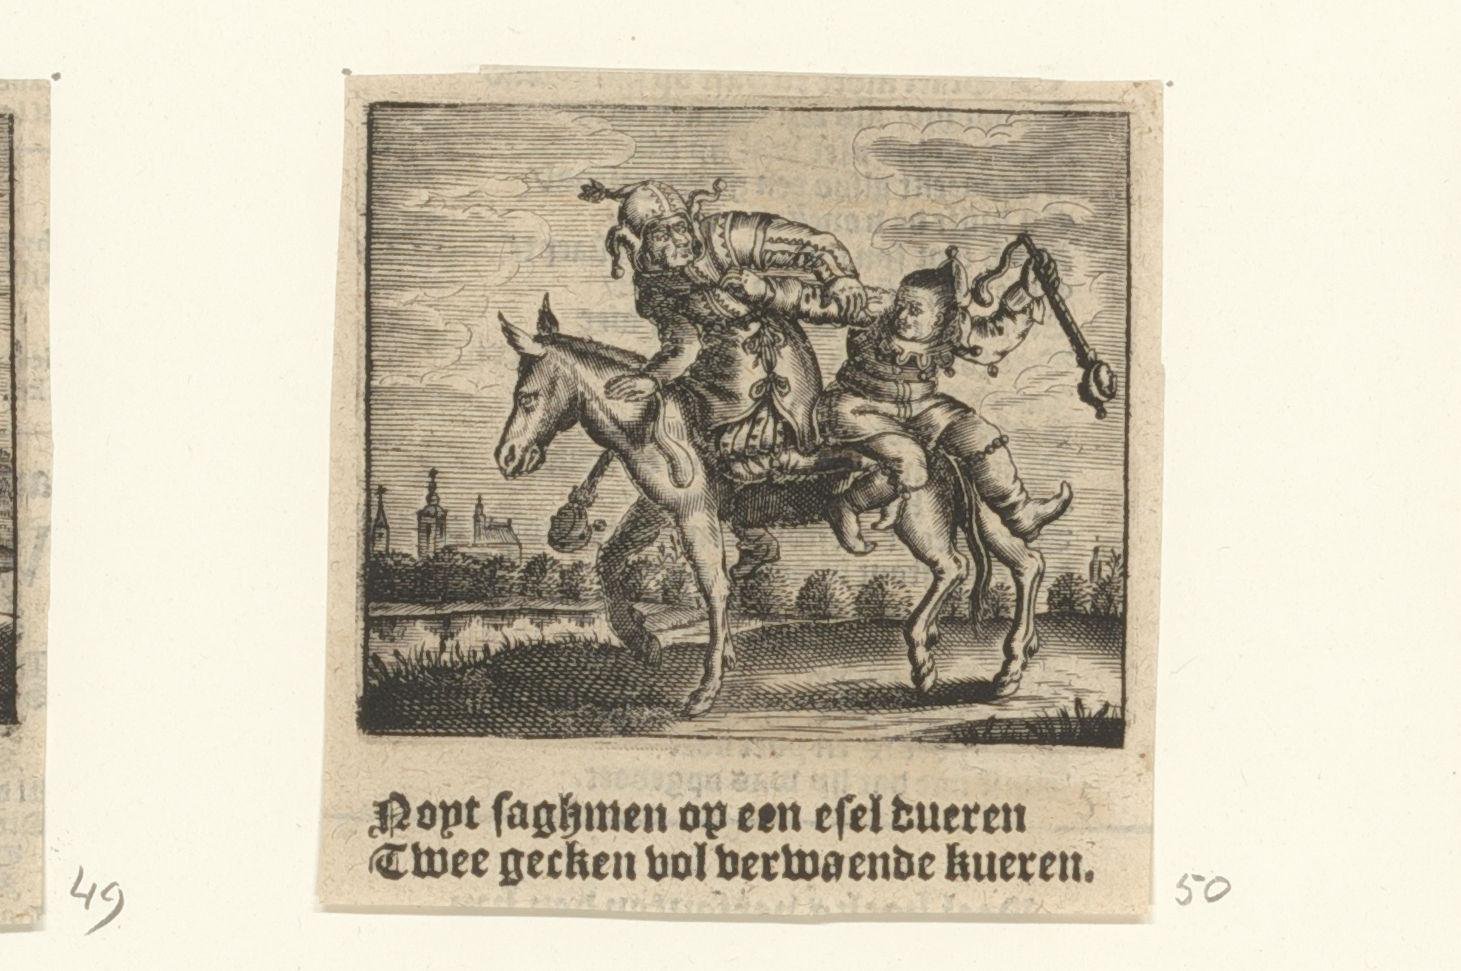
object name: book illustration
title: Noyt saghmen op een esel dueren / Twee gecken vol verwaende kueren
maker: Anonymous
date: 1635-1715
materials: paper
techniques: engraving, letterpress printing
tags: court jester, court fool, proverbs, sayings, etc.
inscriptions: stamp, collector's mark: Lugt 1641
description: Veel versies van dit embleem verschenen in verschillende uitgave van Spiegel van den Ouden ende Nieuwen Tydt. Zoals: Cats, Jacob. Spiegel van den Ouden ende Nieuwen-tijt, Bestaende uyt Spreeck-woorden (...). Dordrecht: Jacob Braat, 1647. Maar ook in andere publicaties (1665, 1671, 1715, 1722).